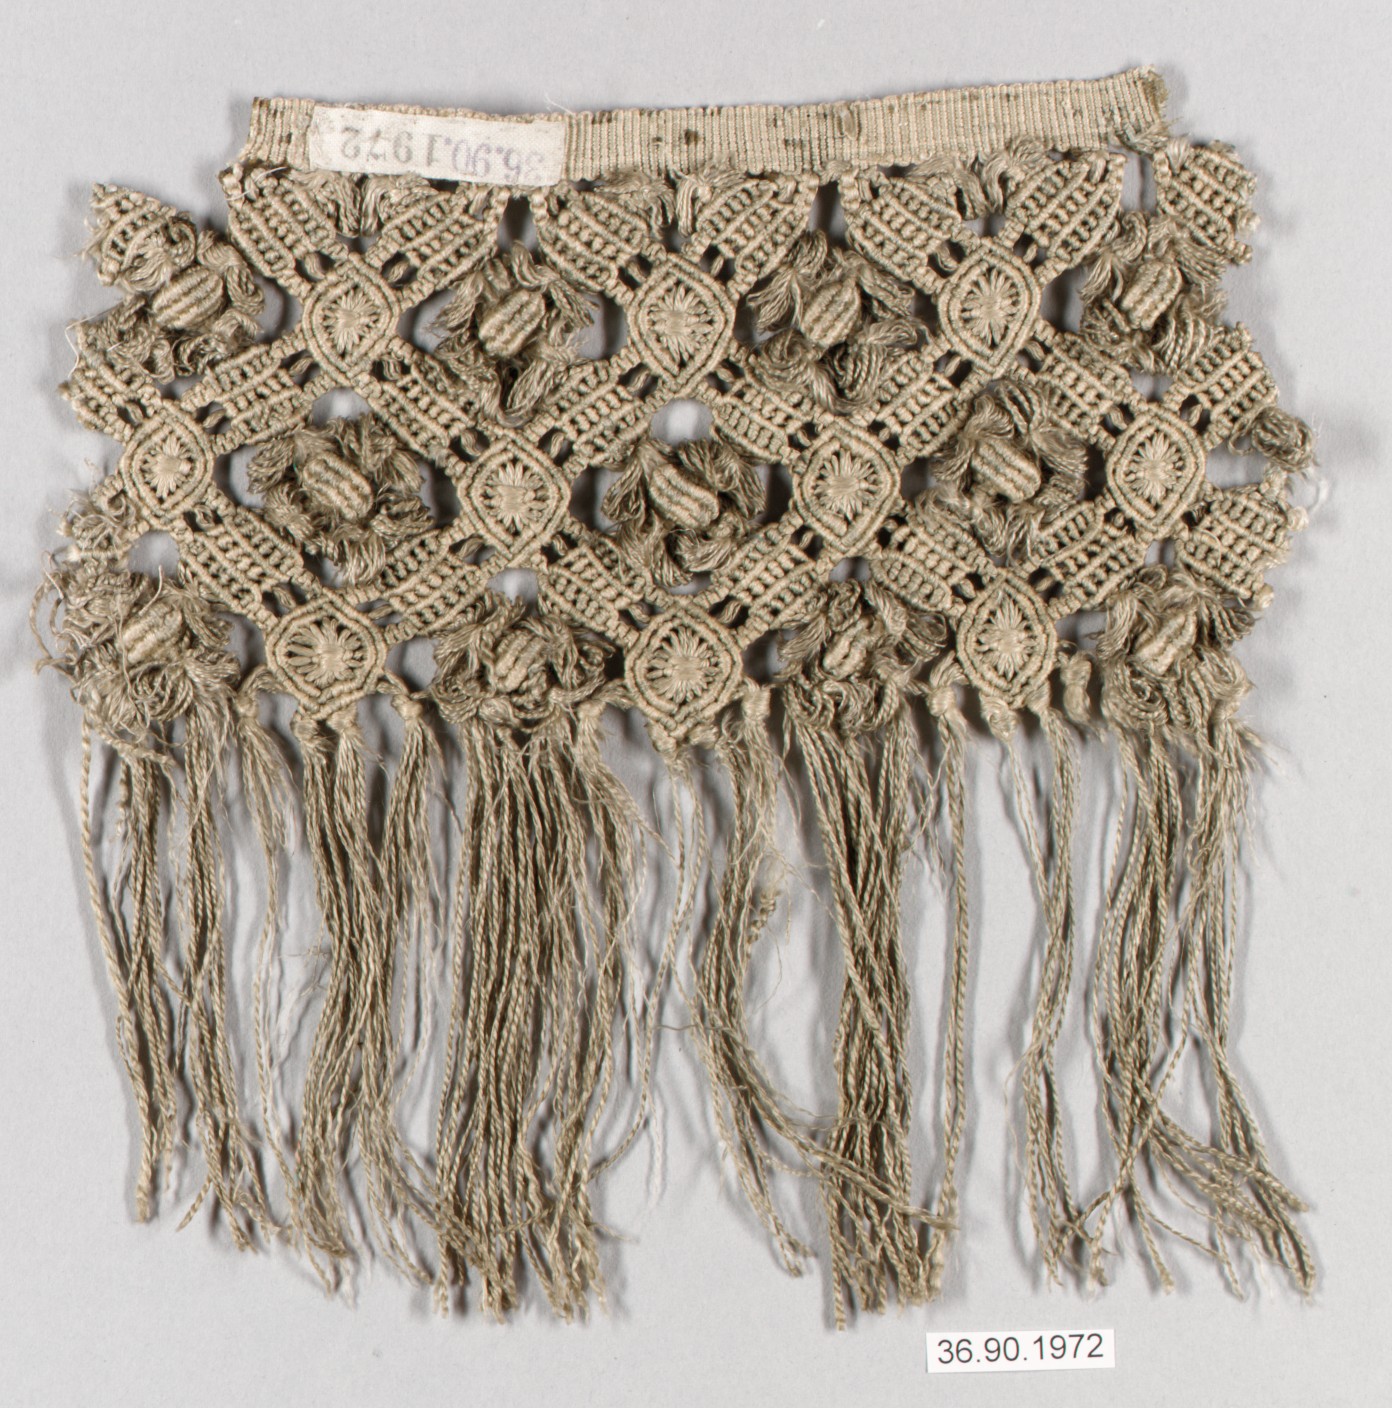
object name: fringe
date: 1801-1833